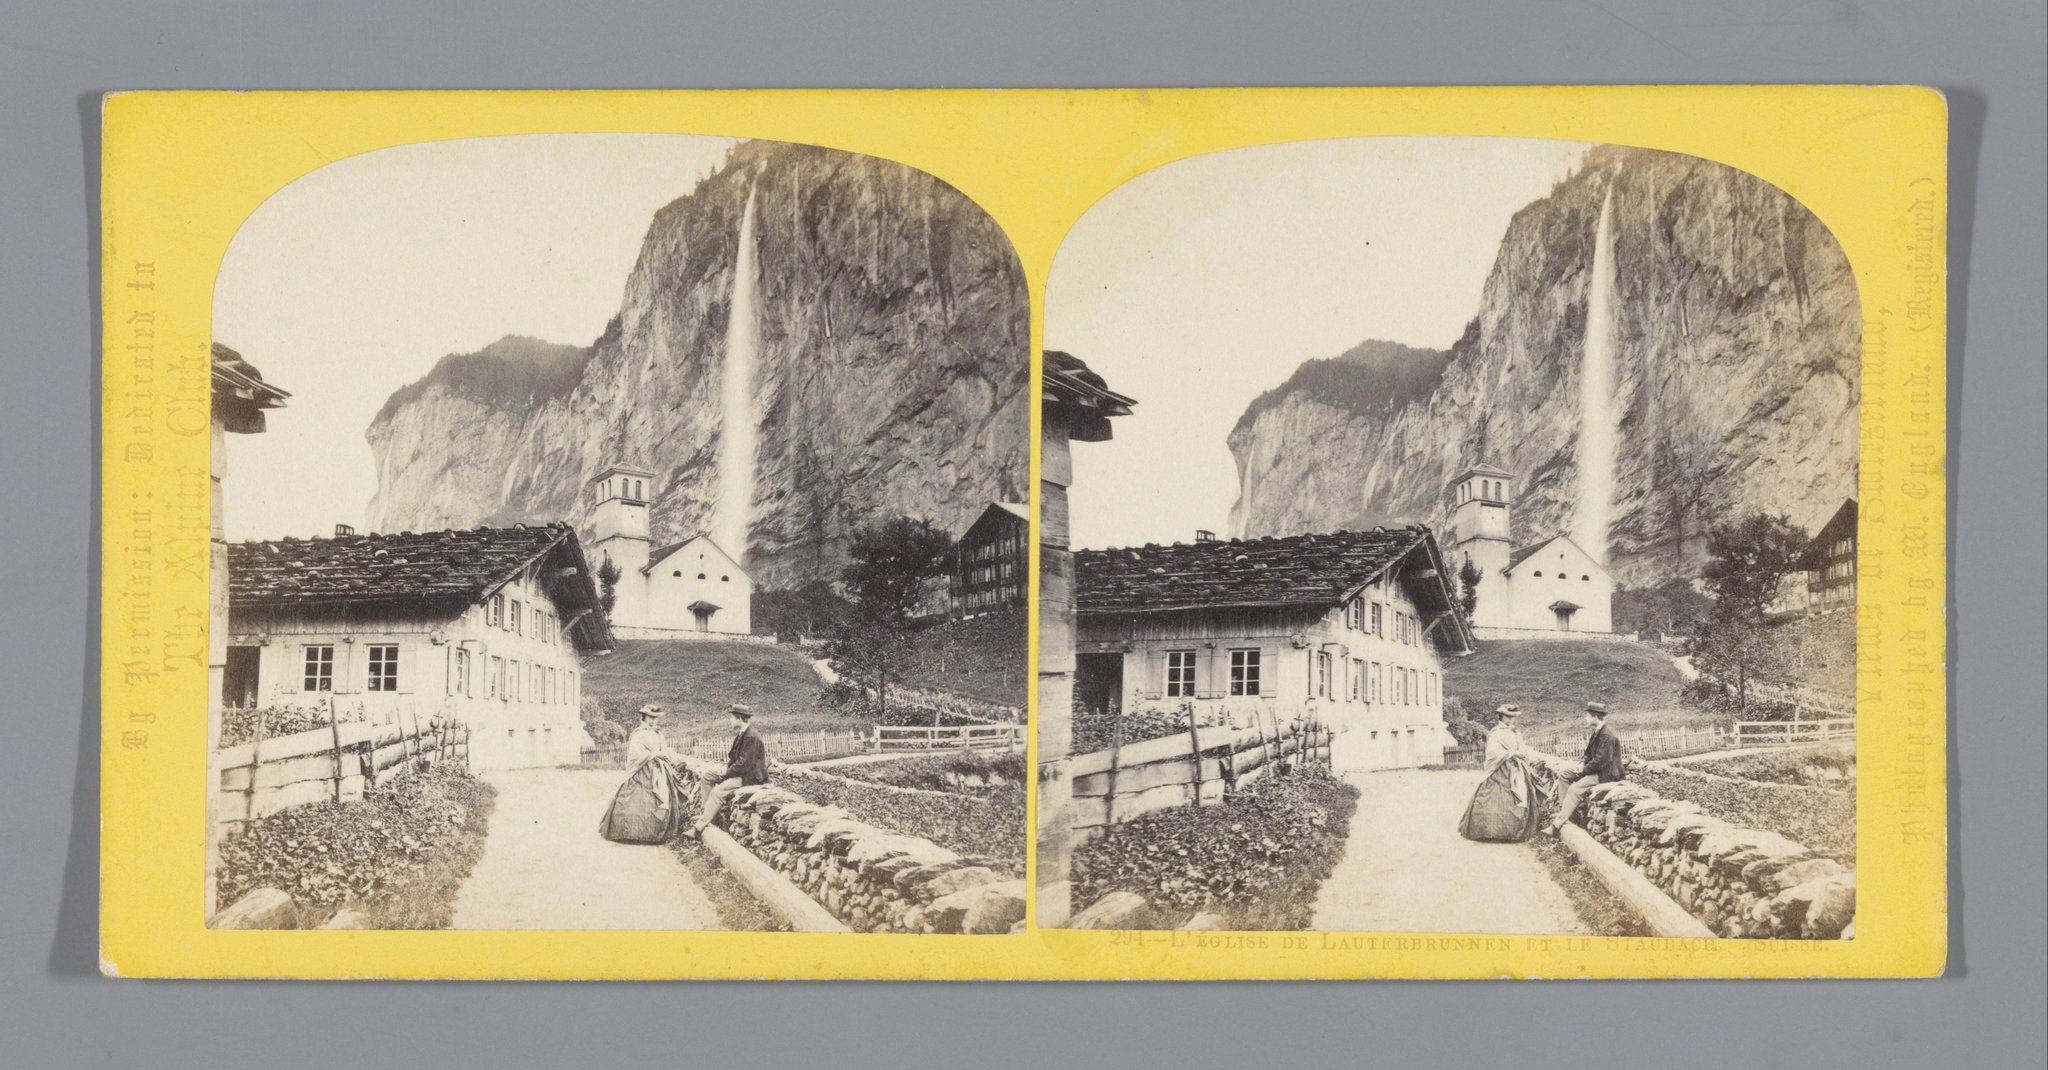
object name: stereograph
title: Gezicht op een kerk te Lauterbrunnen, met op de achtergrond de Staubbachwaterval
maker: william england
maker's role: fotograaf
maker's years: 1816-1896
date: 1850-1880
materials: cardboard, photographic support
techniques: albumen print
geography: lauterbrunnen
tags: waterfall, church (exterior)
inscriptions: number: ‘294.’, inscription: ‘Views of Switzerland, photographed by W. England. (Registered) Under the Special Patronage of the Alpine Club.’